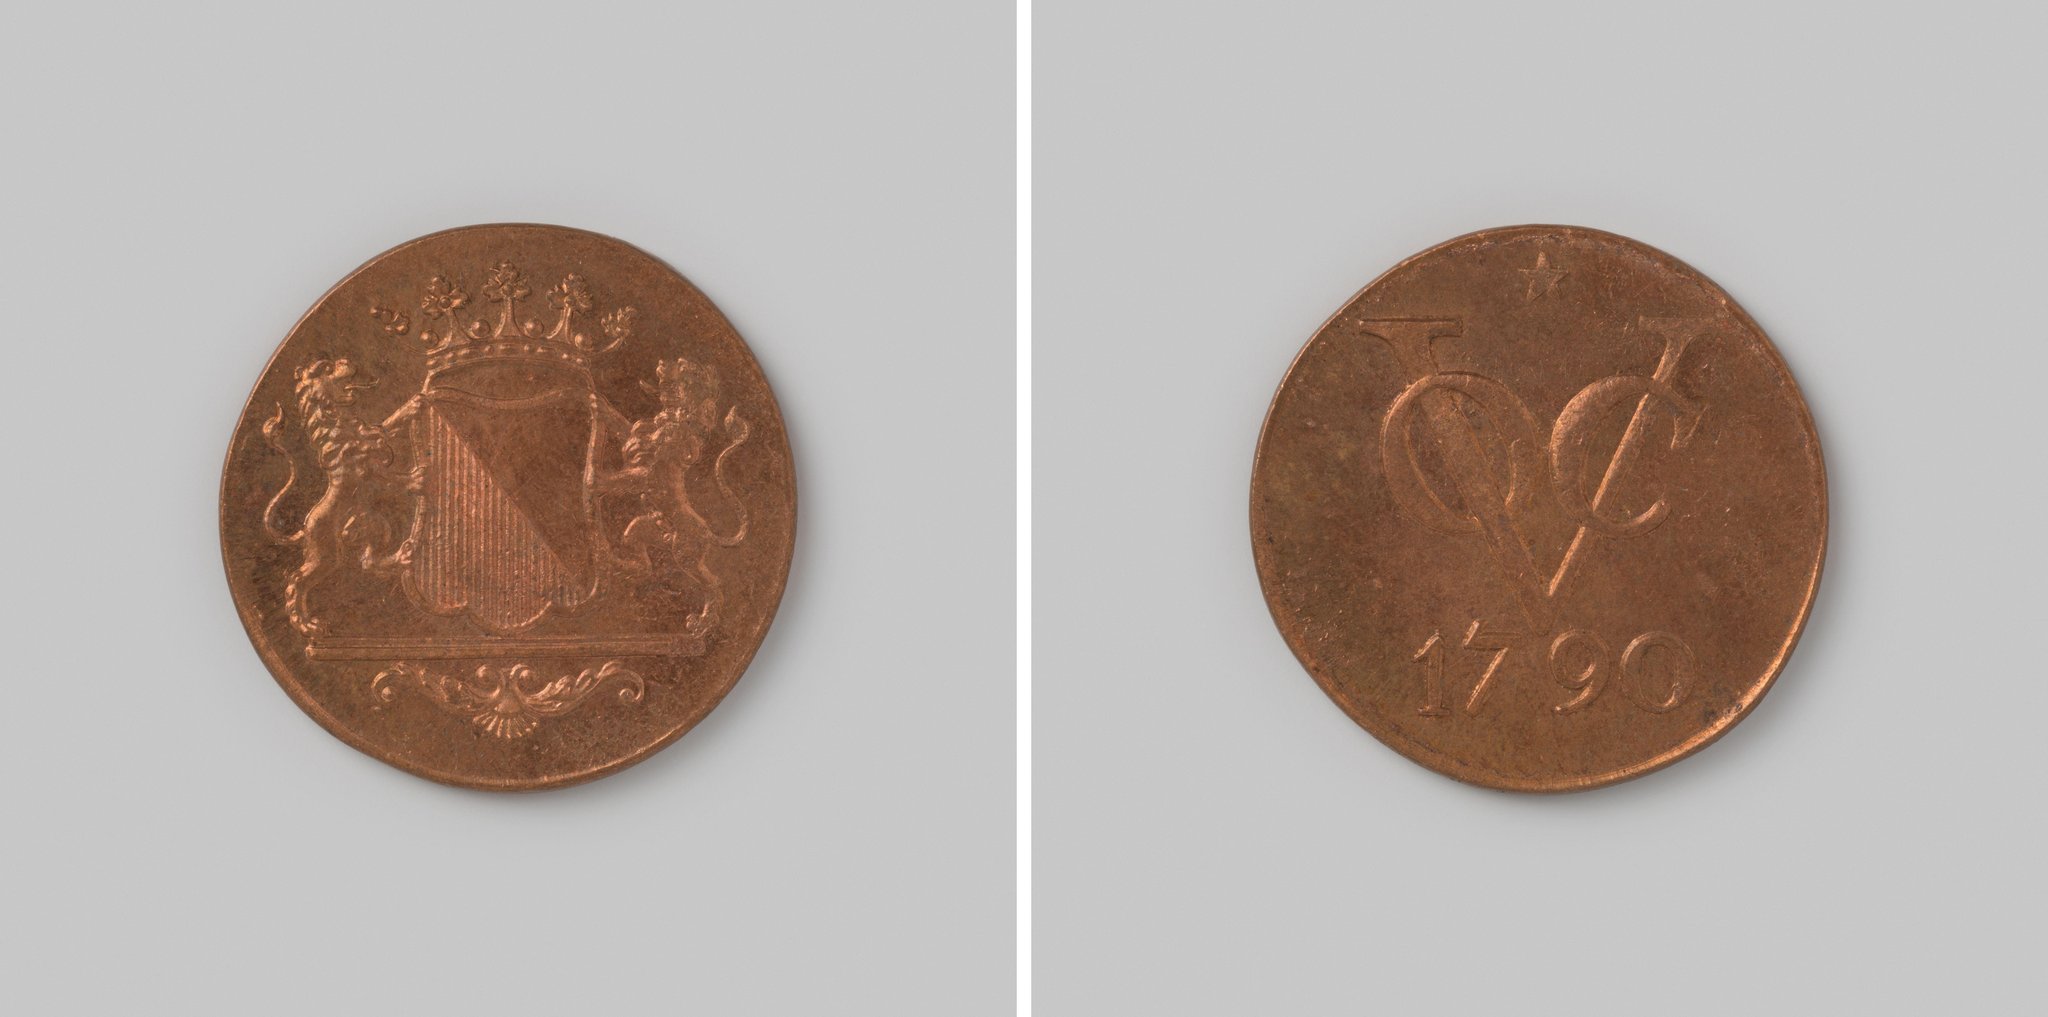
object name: coin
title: Dubbele duit op naam van de VOC en de stad Utrecht met jaartal 1790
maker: william ii of the netherlands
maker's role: koning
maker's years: 1792-1849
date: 1840-1843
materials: copper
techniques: striking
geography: surabaya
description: Koperen munt. Voorzijde: op balk, waaronder guirlande, staand, door twee leeuwen gehouden gekroond wapenschild van de stad Utrecht. Keerzijde: monogram van de VOC, waarboven muntteken ster en waaronder fictief jaartal 1790. Gladde rand.